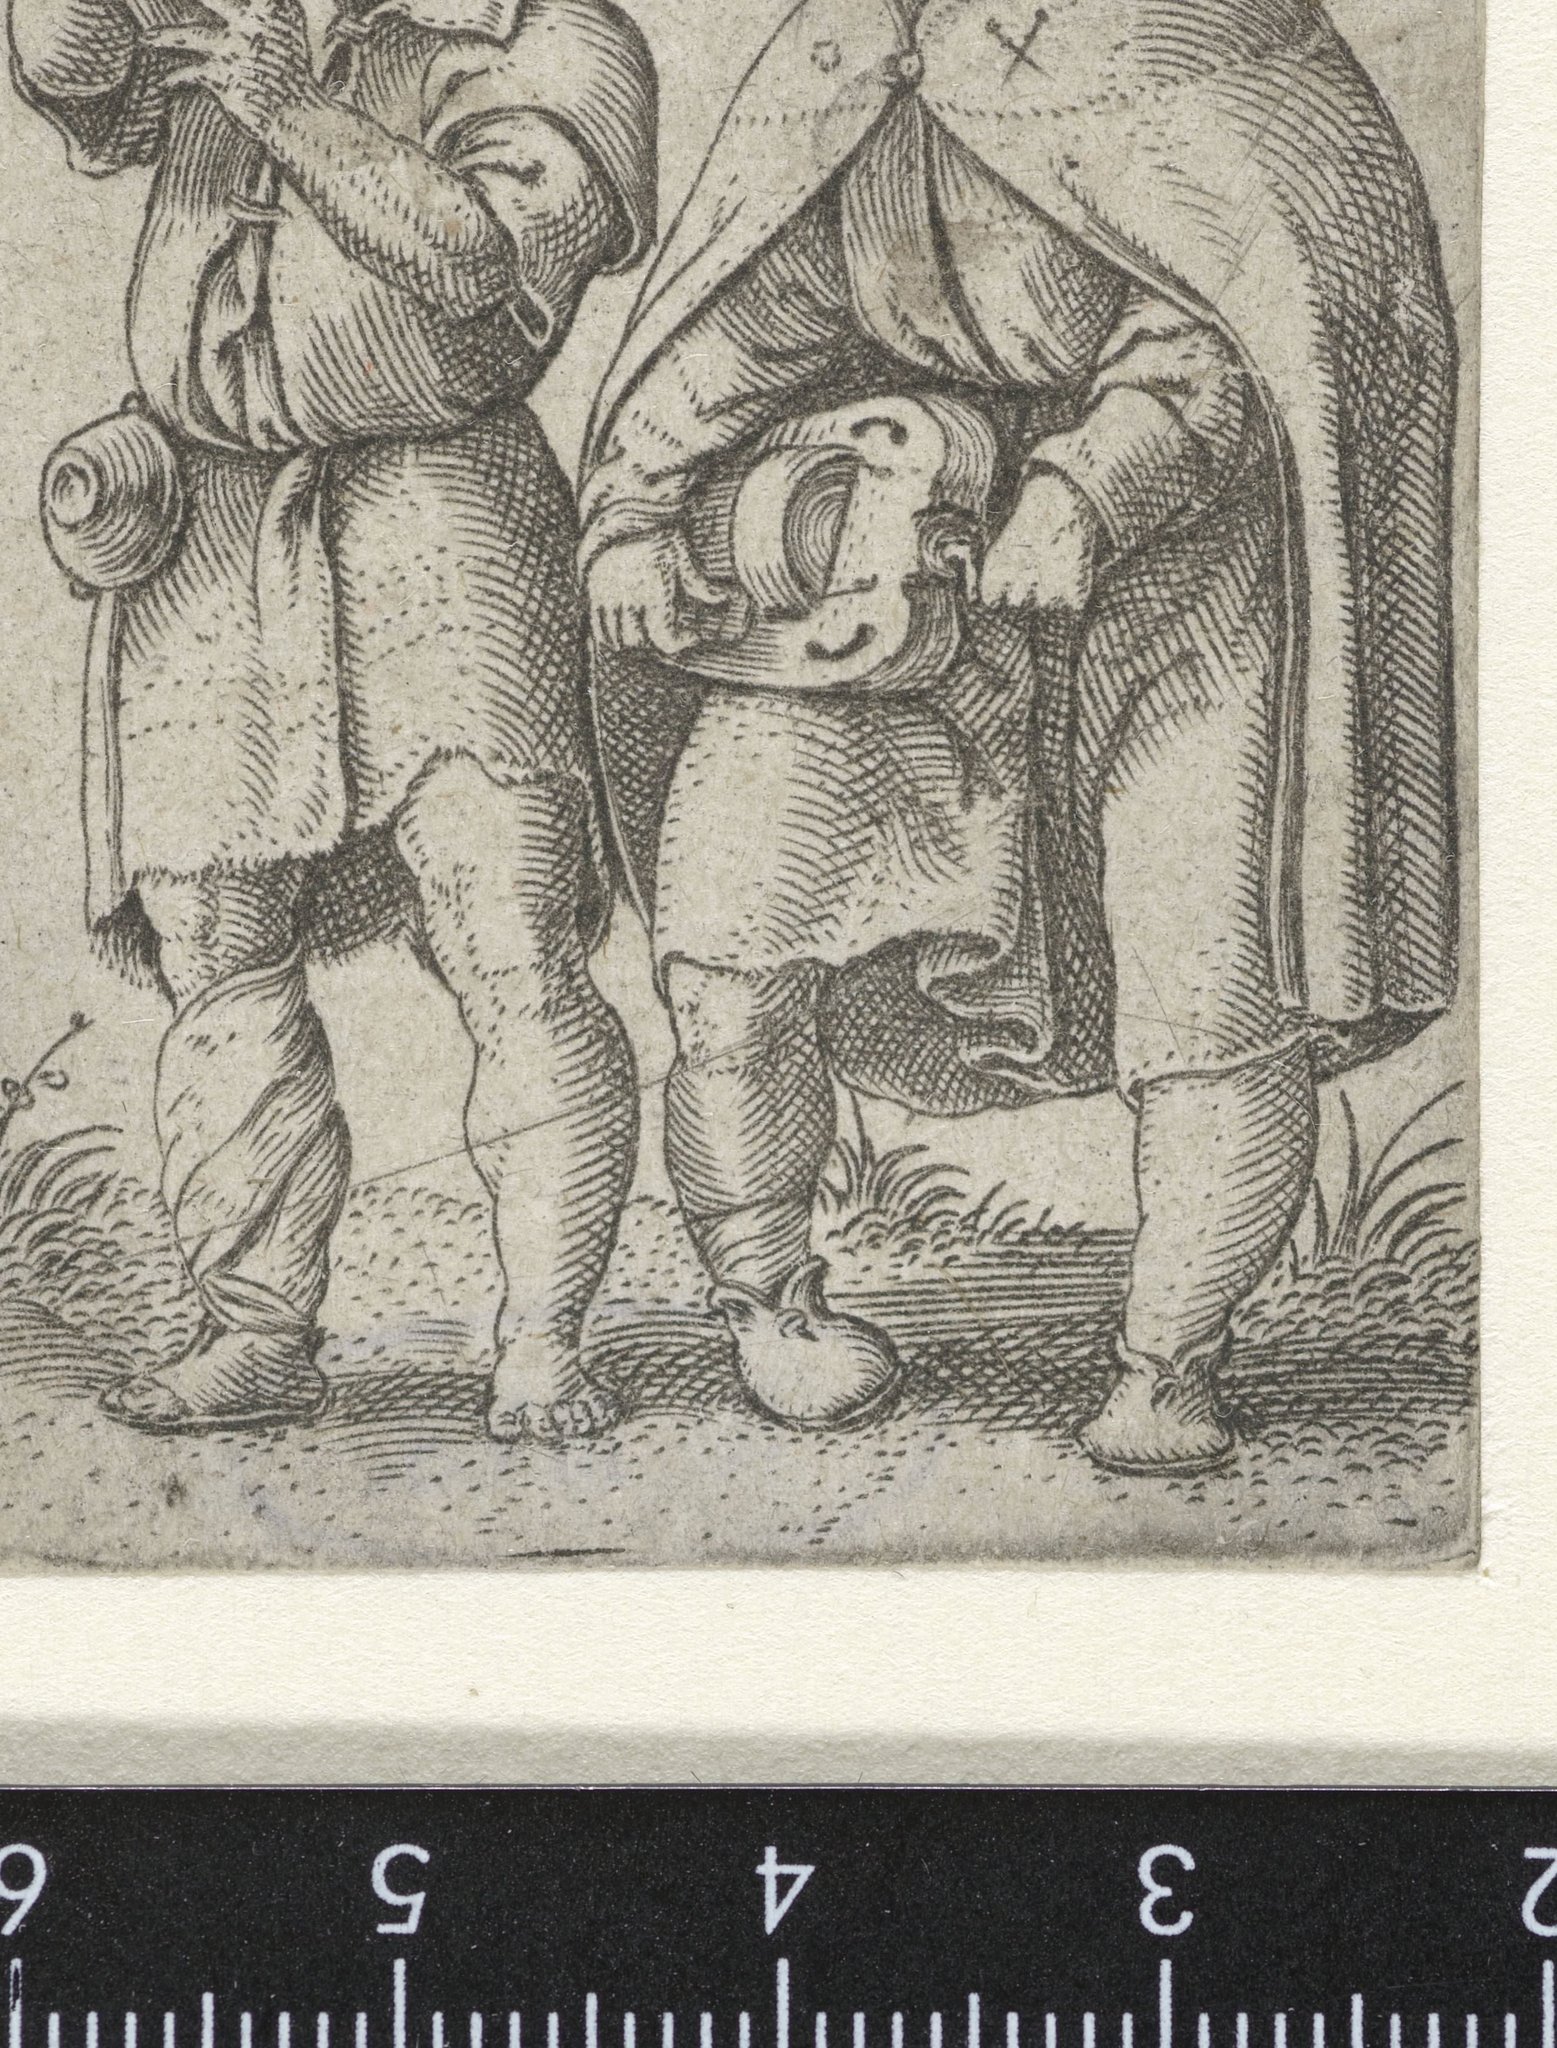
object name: print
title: Musicerende bedelaars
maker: cornelis massijs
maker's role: painter, print maker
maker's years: 1510-1557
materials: paper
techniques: engraving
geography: antwerp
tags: dancing, crutches, person with a physical disability, social stratification, social groups, hurdy-gurdy player, folk costume, regional costume, clappers, castanets, beggar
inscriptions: collector's mark: Lugt 2228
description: In de tijd waarin deze serie ontstond was 'kreupel' een generiek woord om een lichamelijke beperking aan het onderlichaam te beschrijven. Deze serie is sociale satire. Twee bedelaars, één met castagnetten in de handen en de ander met een draailier. De linker heeft een nap aan zijn riem hangen en een bandage om zijn been.